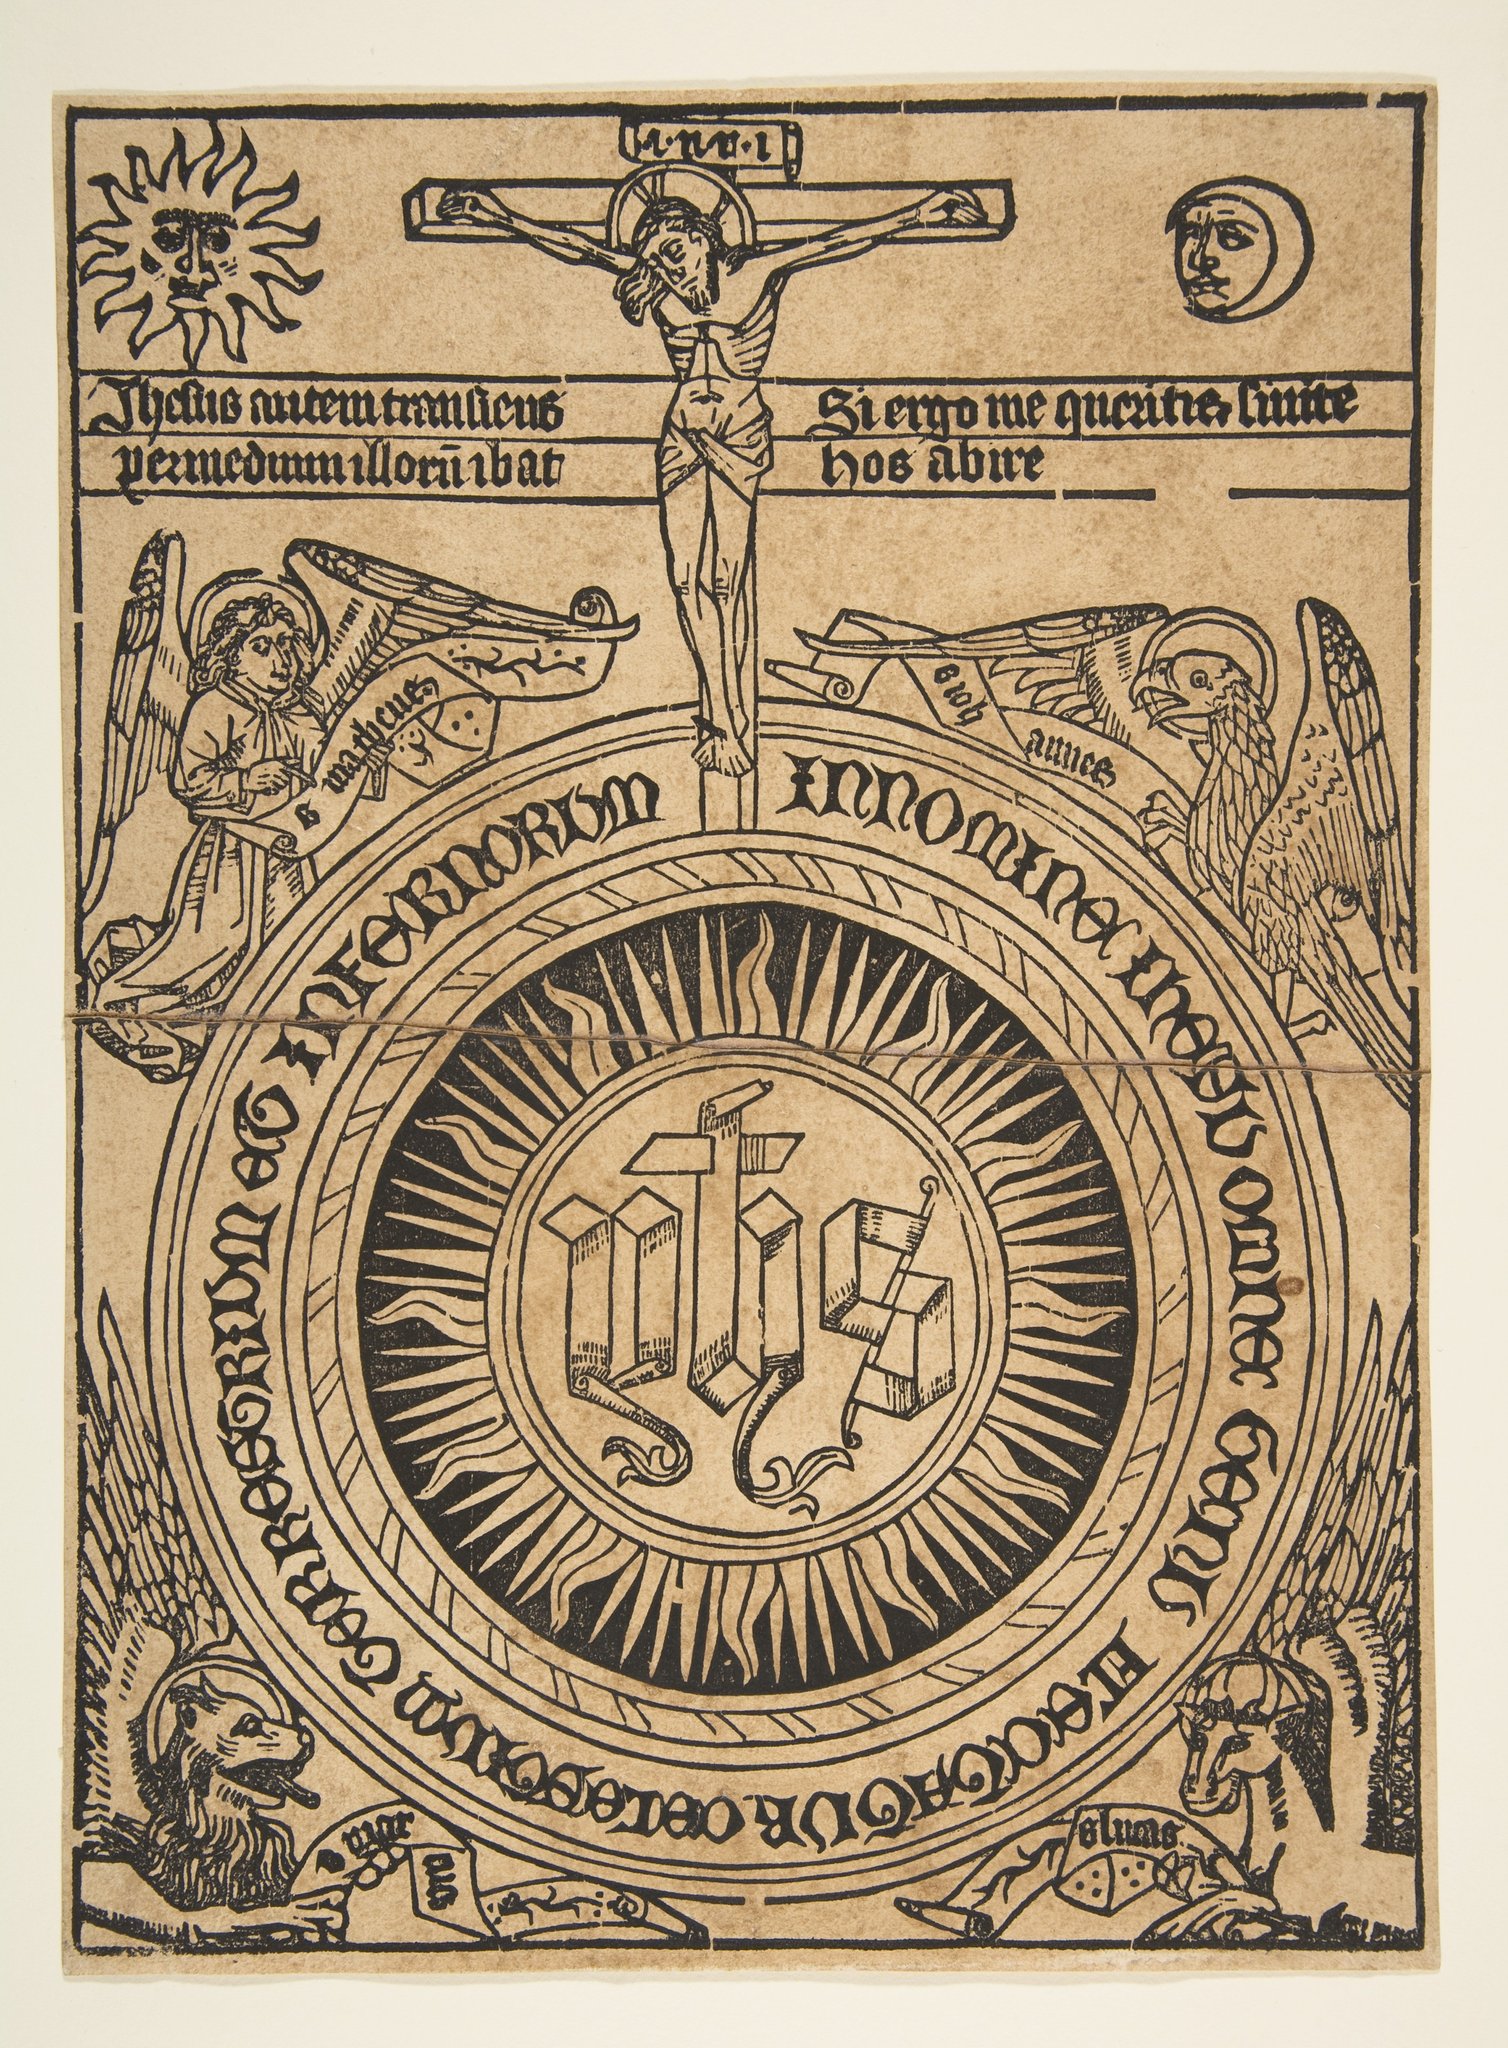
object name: print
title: The Sacred Monogram with the Symbols of the Evangelists and the Crucifixion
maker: anonymous, german, 15th century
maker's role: artist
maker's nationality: german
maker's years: 1400-1500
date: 1401-1500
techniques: woodcut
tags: birds,angels,christ,crucifixion